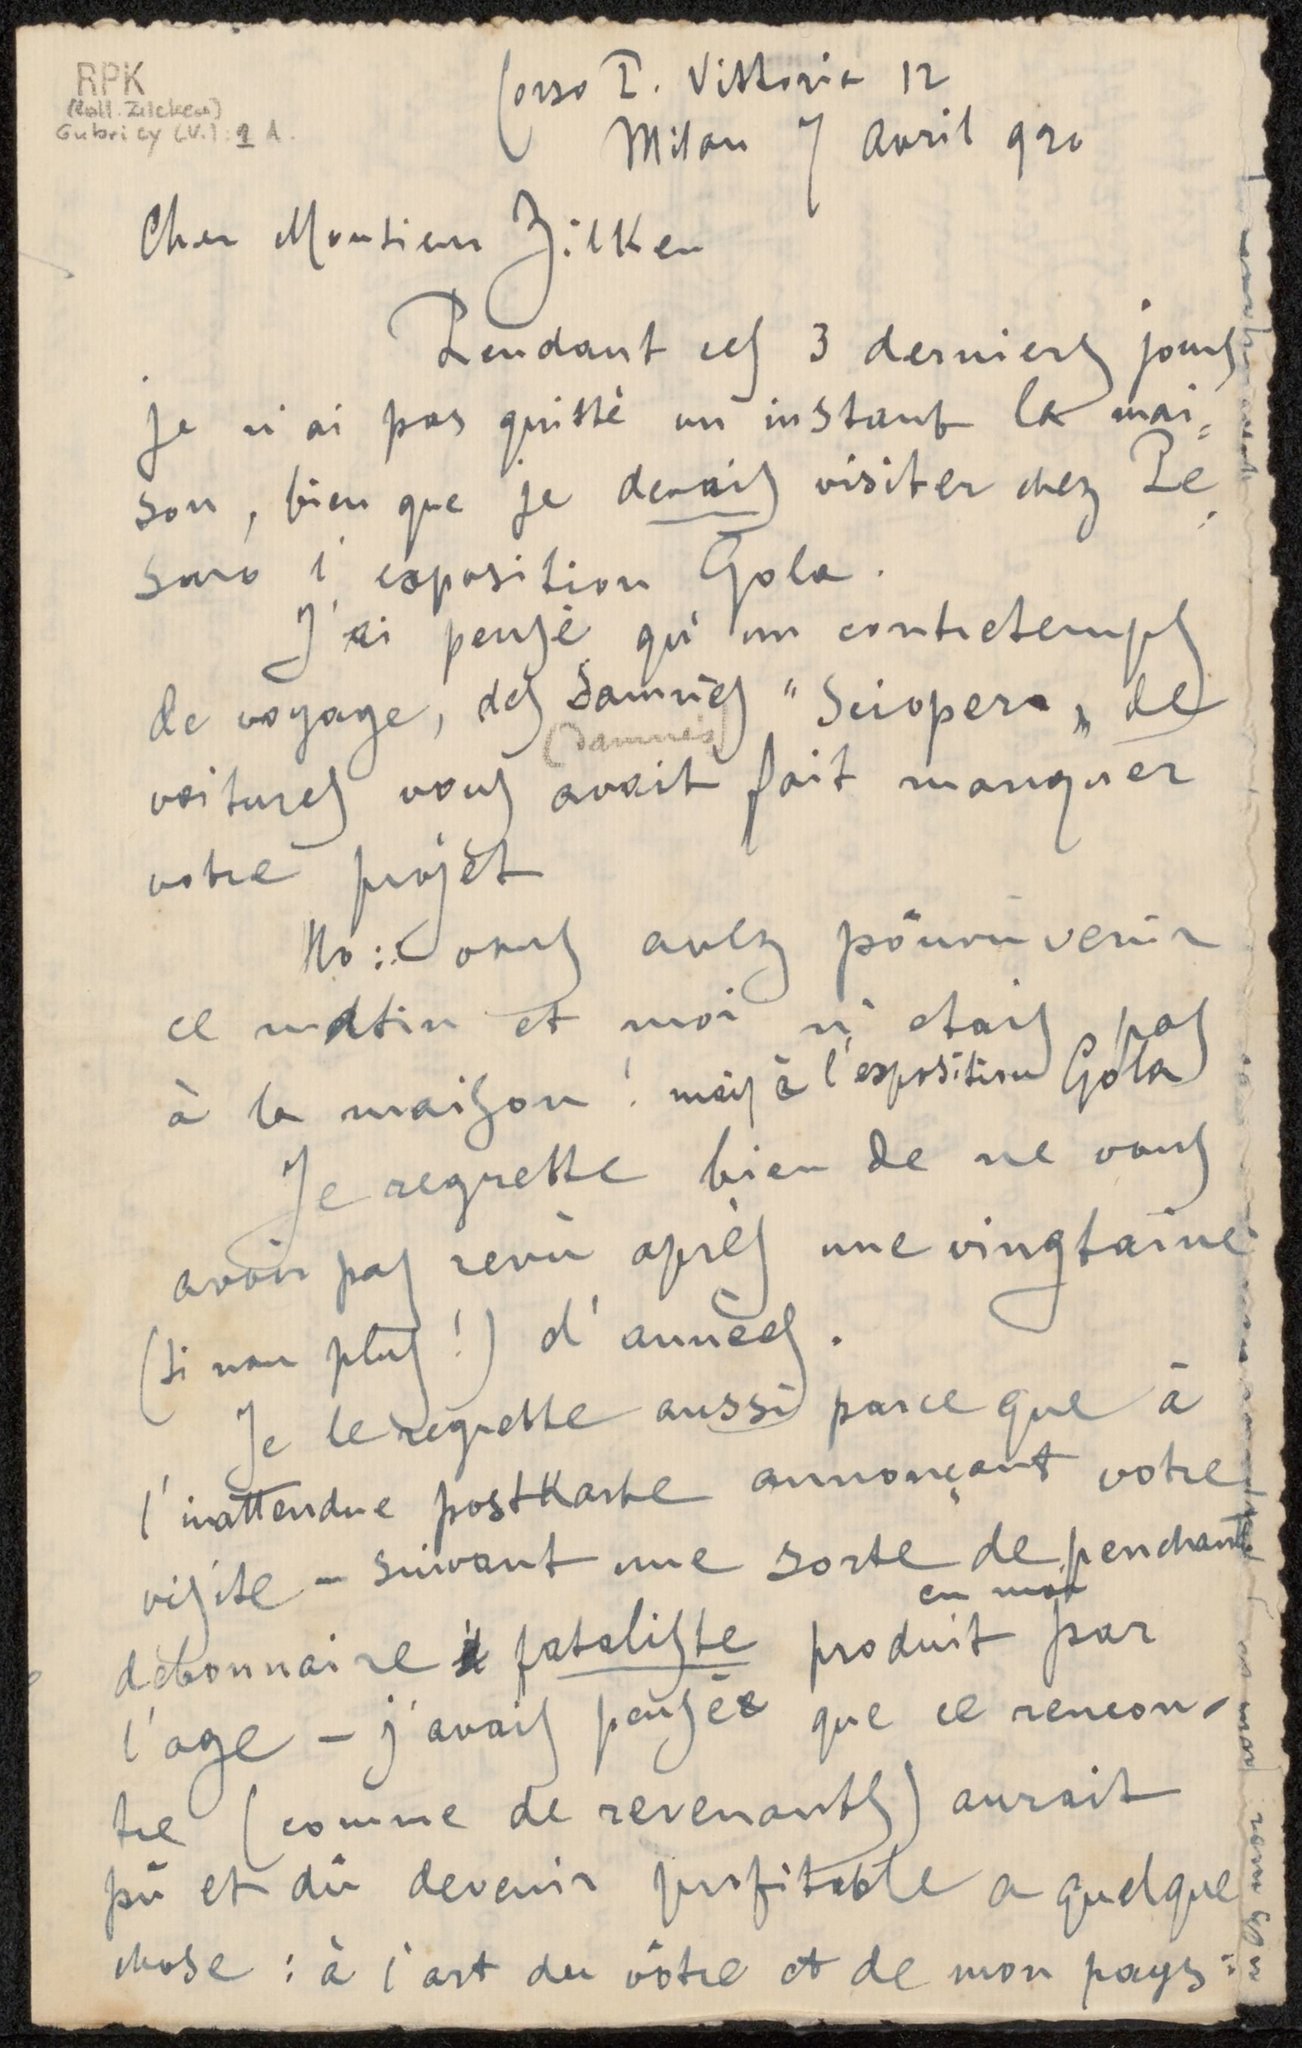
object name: letter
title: Brief aan Philip Zilcken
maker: vittore grubicy de dragon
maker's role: painter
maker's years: 1851-1920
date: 1920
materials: ink, paper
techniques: pen, writing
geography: milan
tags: print maker, jozef israëls, rotterdam, george hendrik breitner, willem maris, draughtsman, david adolph constant artz, amsterdam, bernard eilers, elbert jan van wisselingh, philip zilcken, exhibition ~ art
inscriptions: collector's mark: ‘RPK’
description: Vormt samen met RP-D-1982-43-GUBRICY(V.)-1B een doorlopende brief.